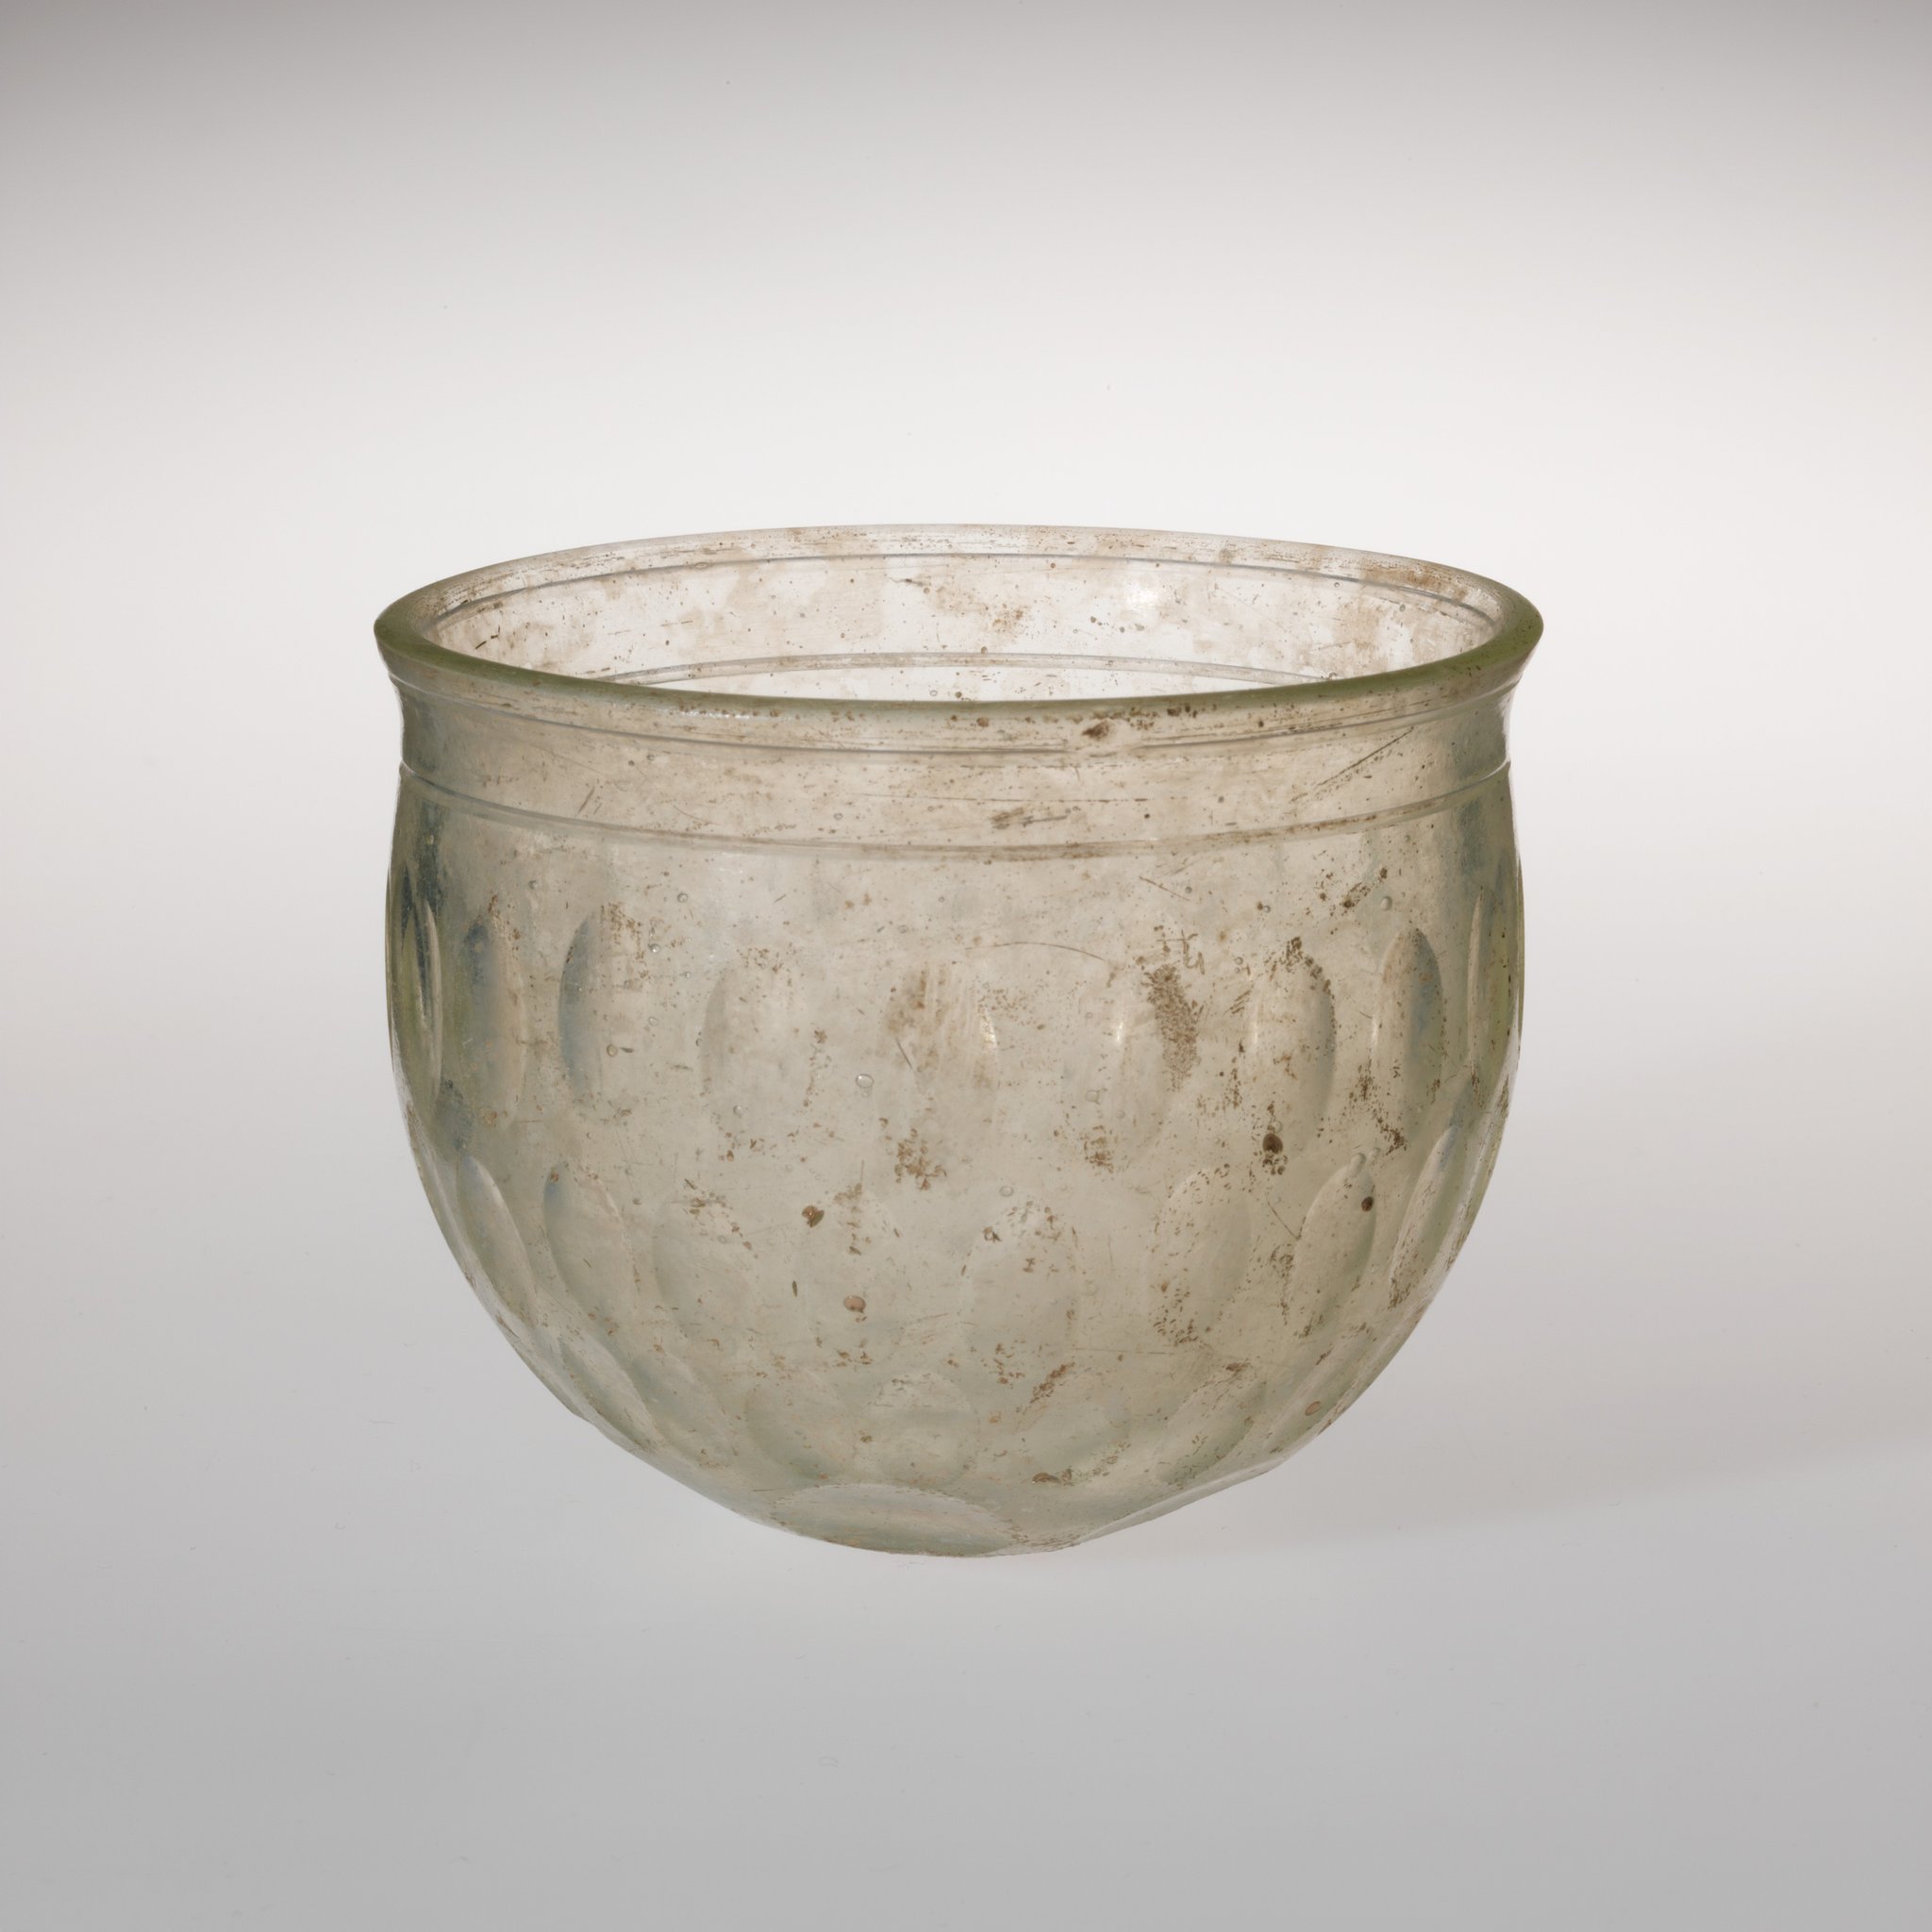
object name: bowl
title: Glass bowl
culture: roman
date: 201-400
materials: glass